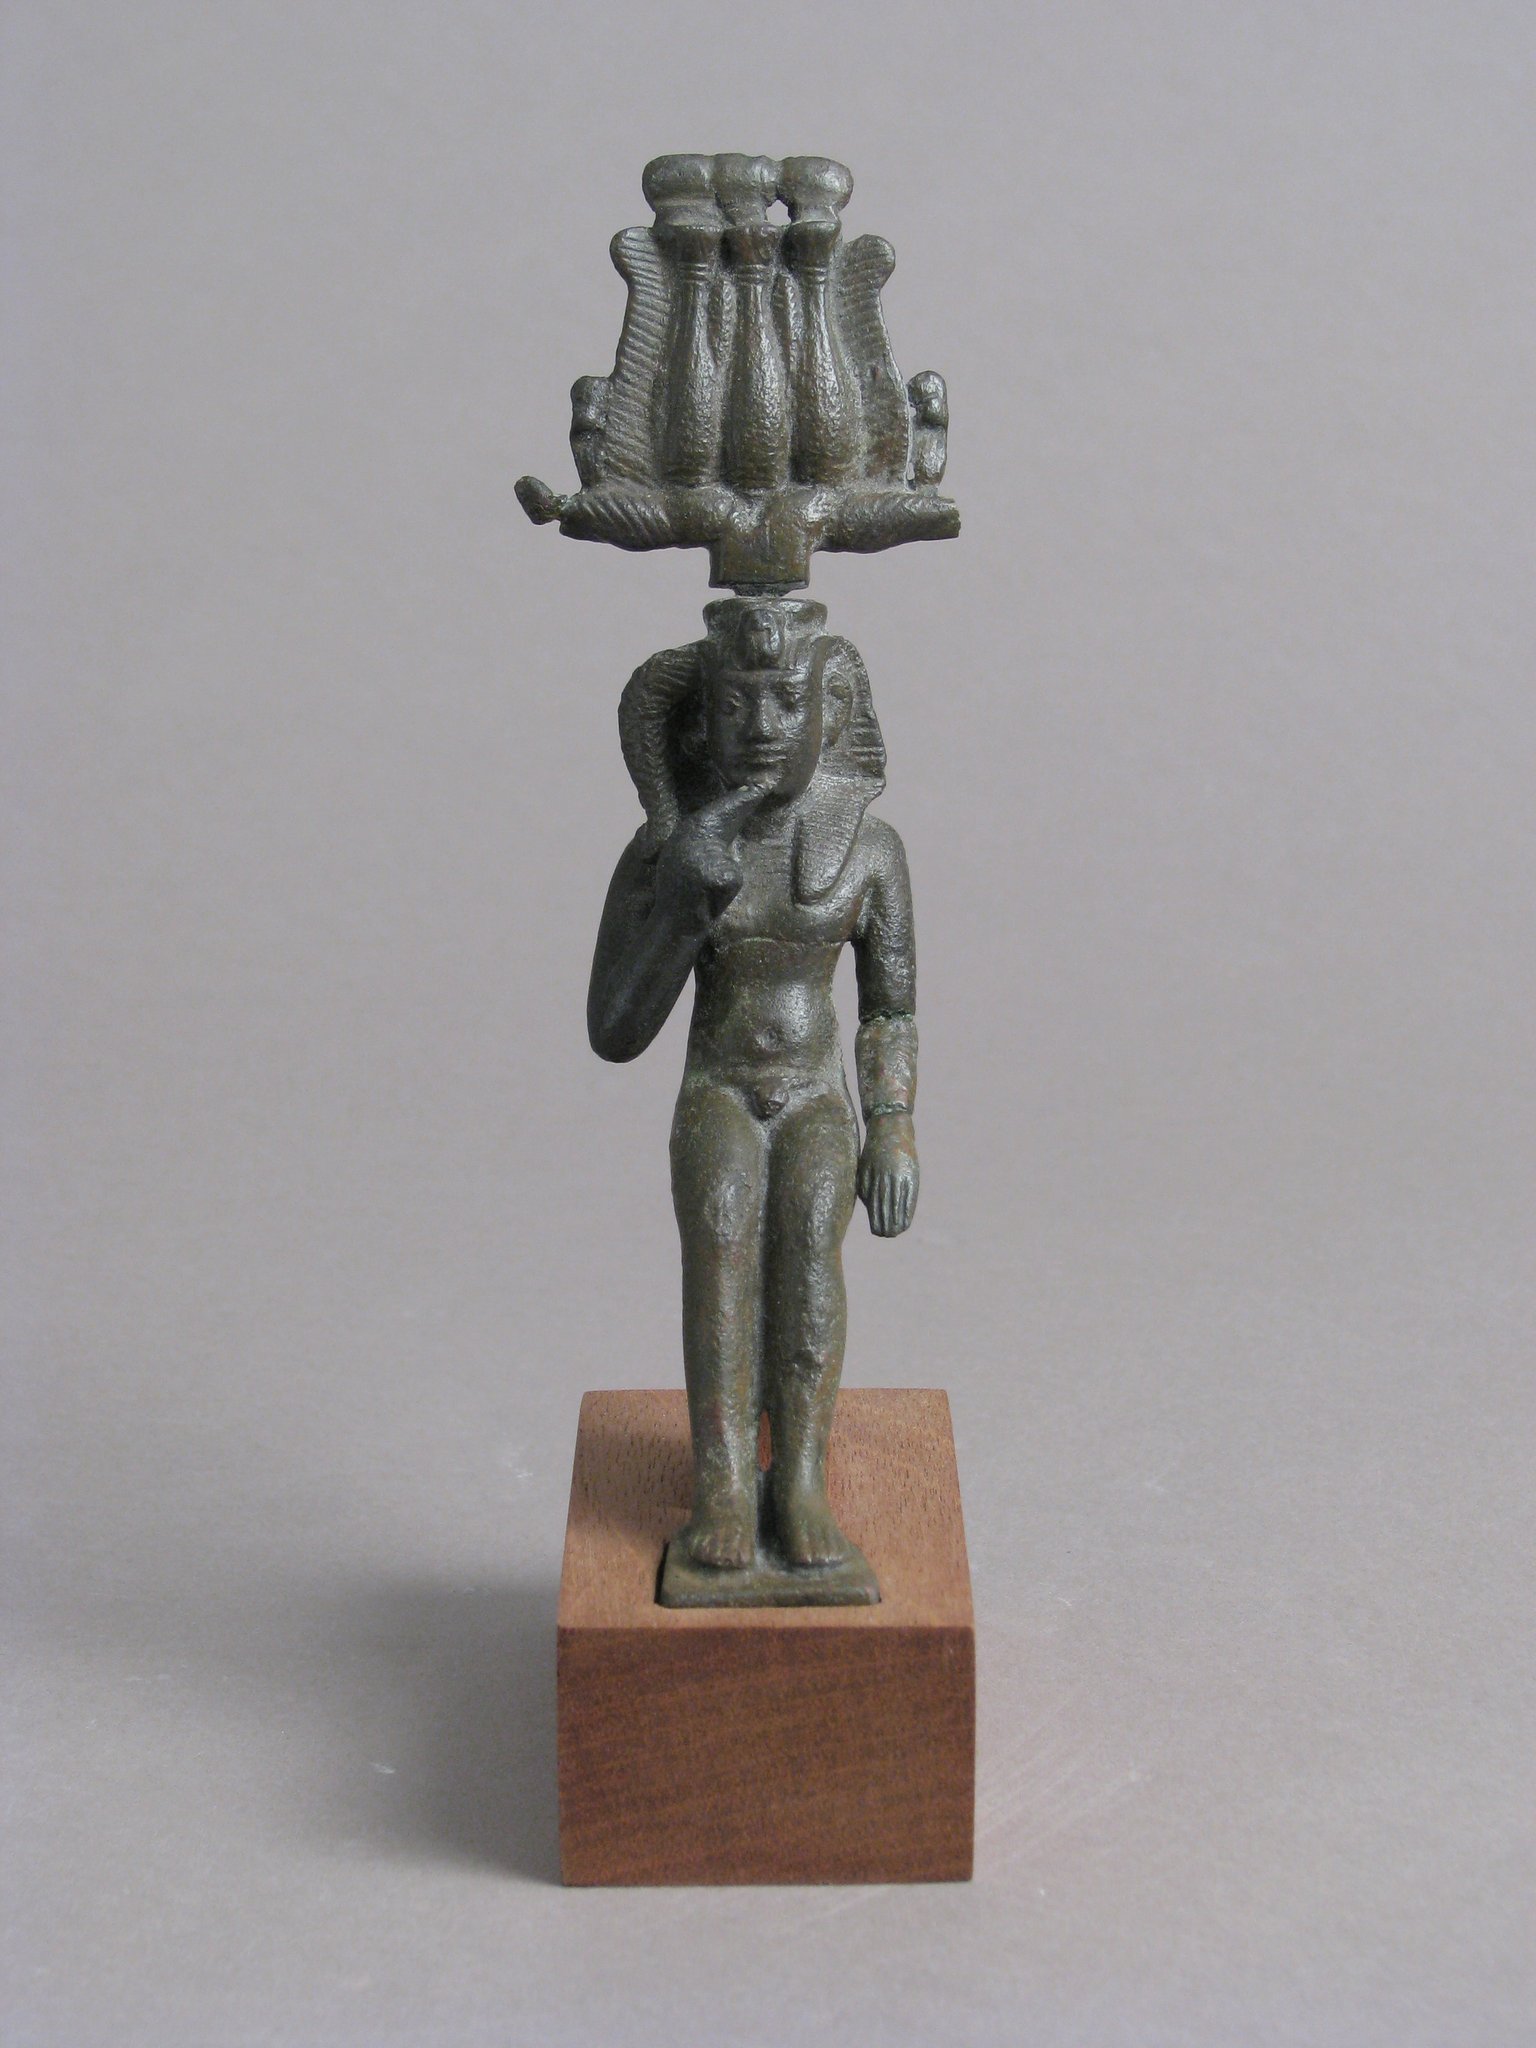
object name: statuette, harpokrates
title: Harpokrates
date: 712-30 BCE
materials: bronze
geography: egypt